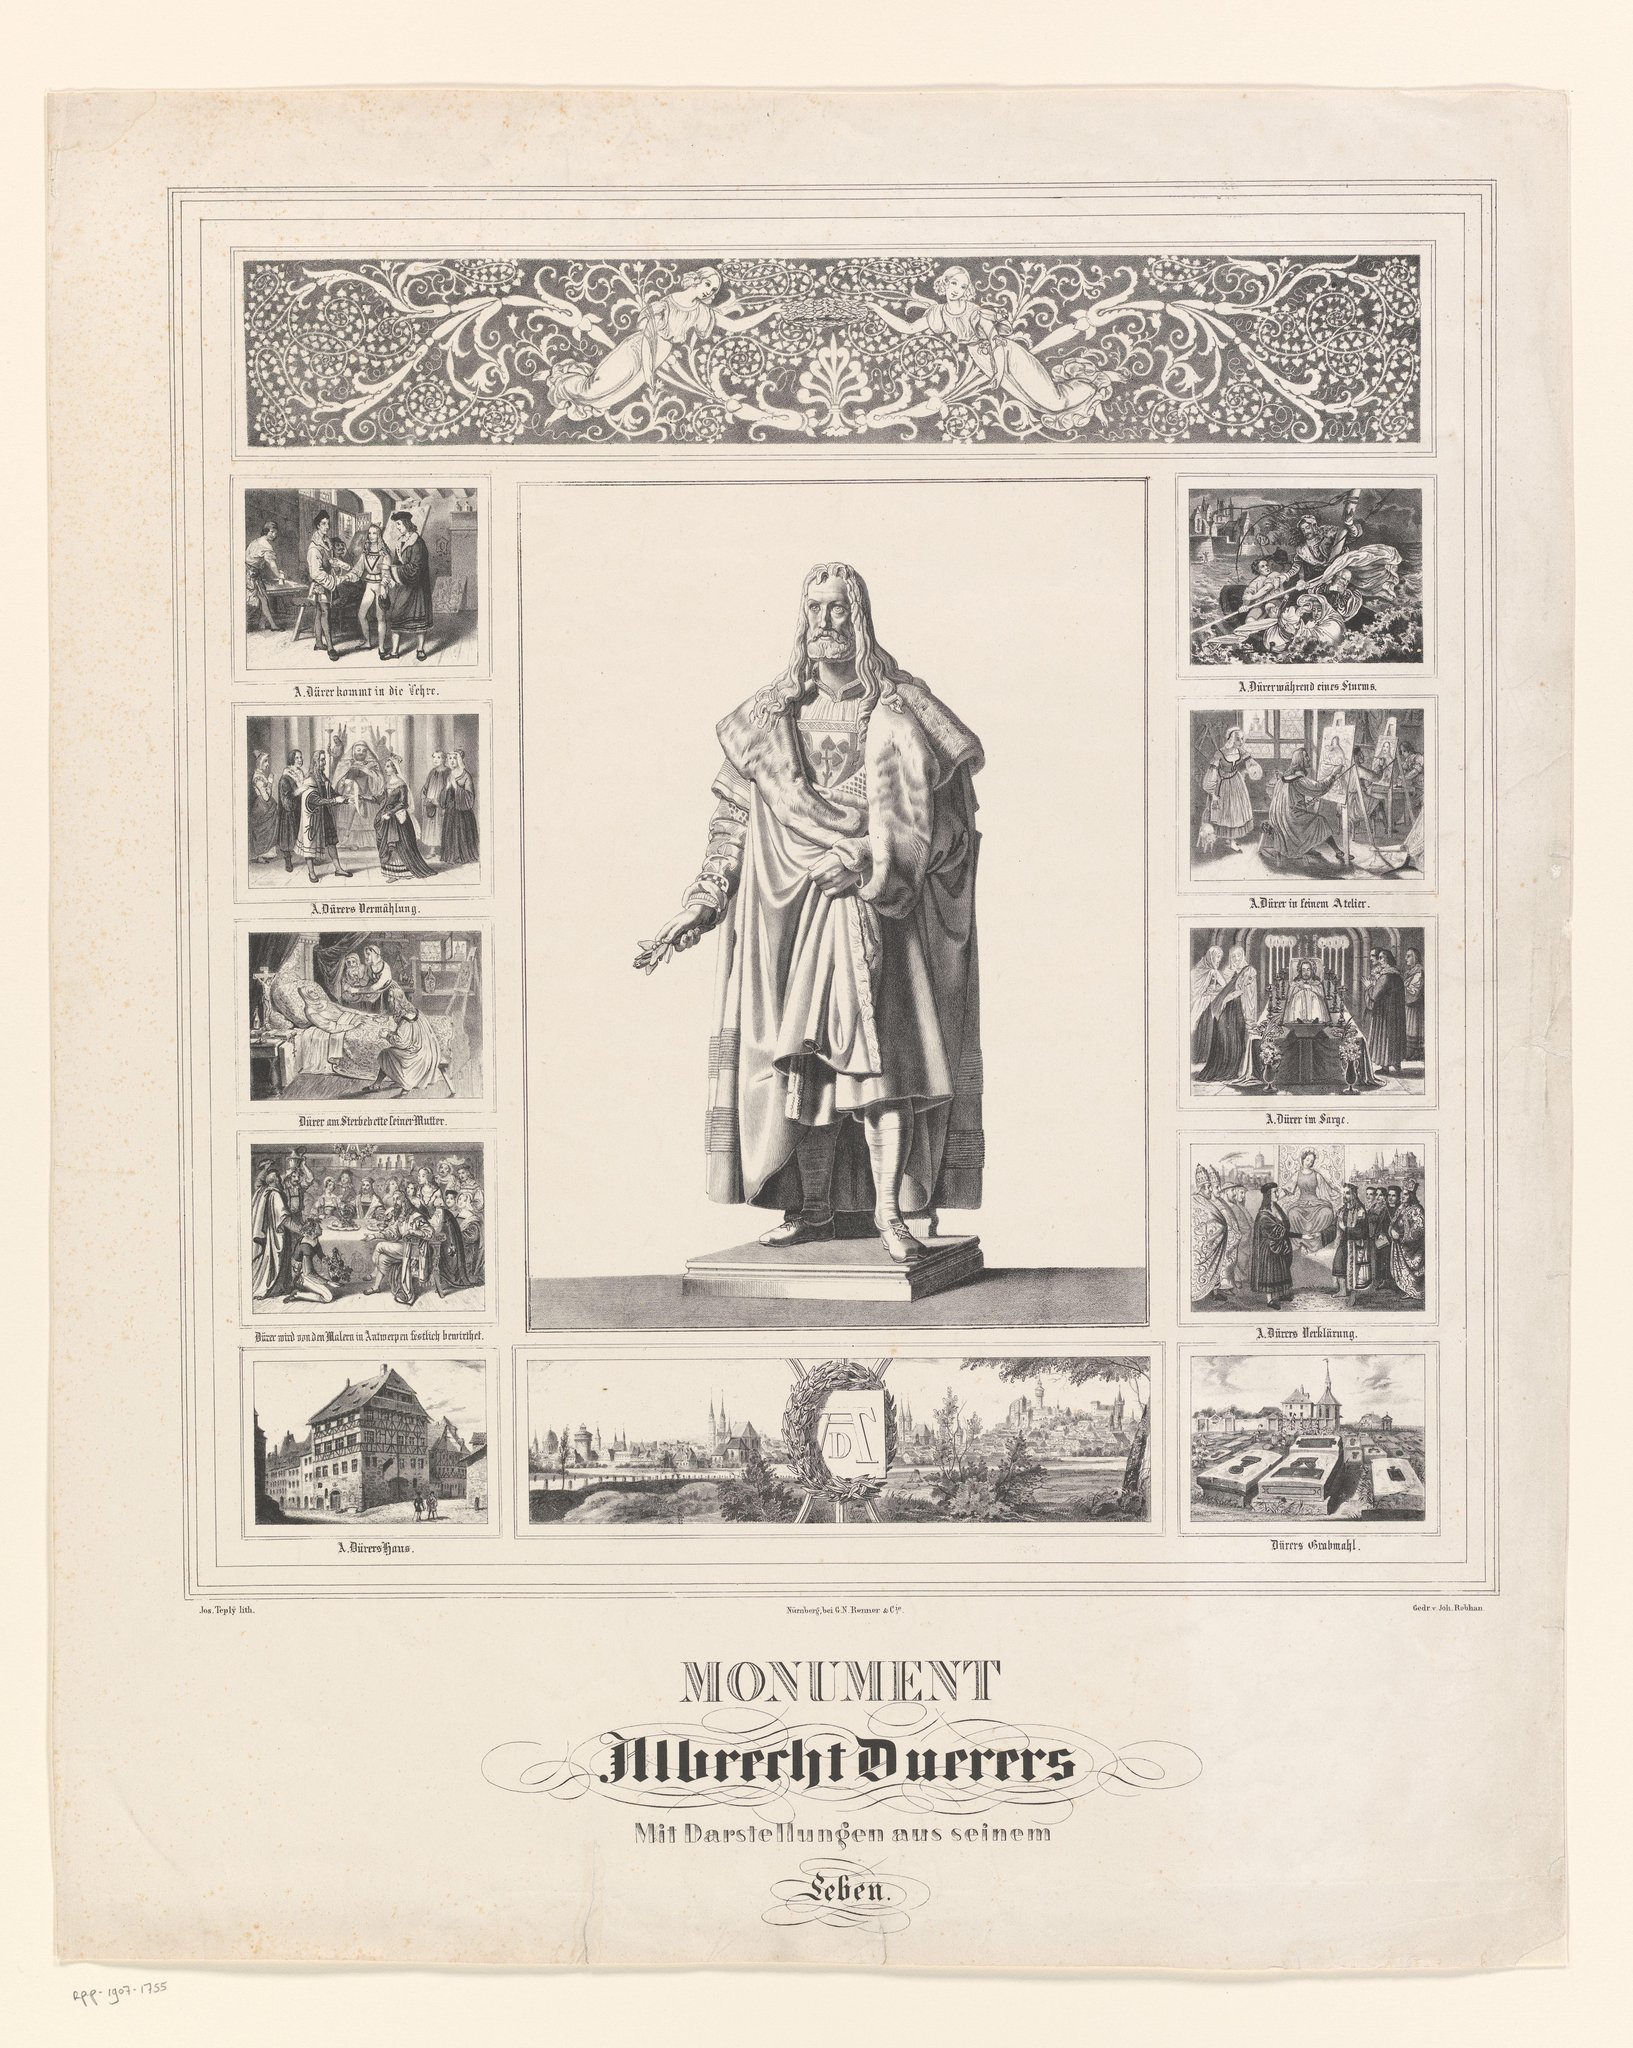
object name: print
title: Monument Albrecht Duerers mit Darstellungen au seinem Leben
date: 1824-1860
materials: paper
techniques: lithograph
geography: nuremberg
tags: painter, print maker, draughtsman, albrecht dürer, city-view, and landscape with man-made constructions, monument, statue, artist (in general)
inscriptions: collector's mark: Lugt 2228